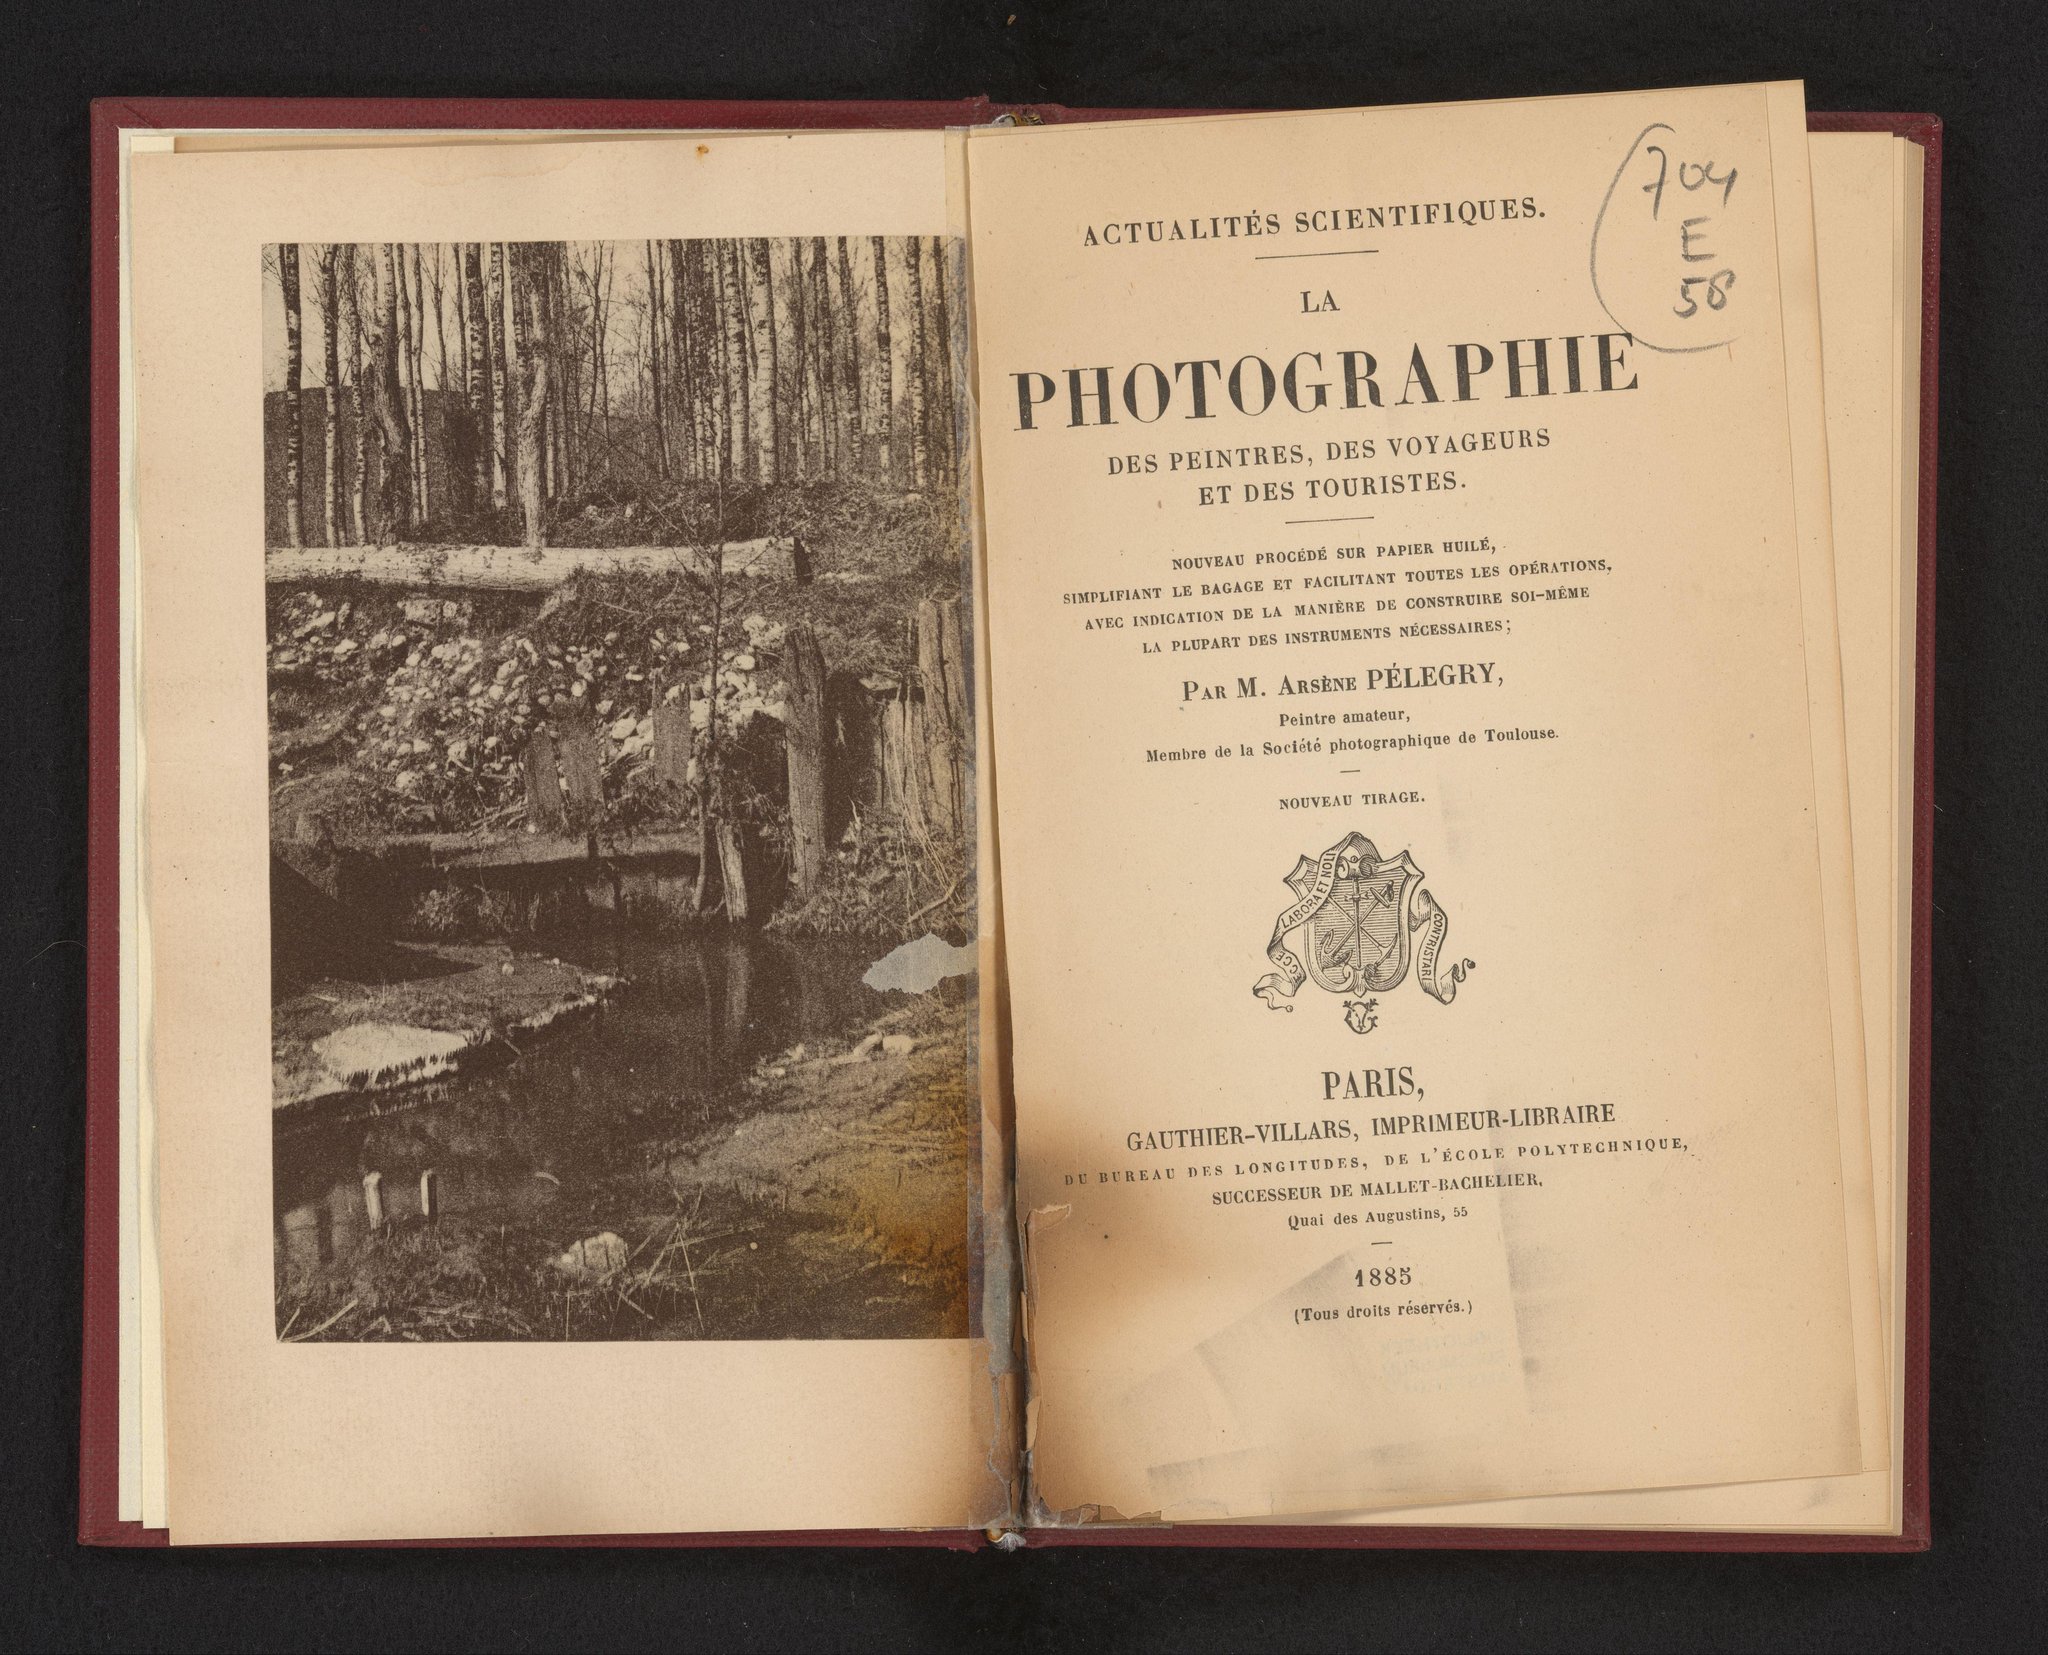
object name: page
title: Gezicht op een bos met beek en een omgevallen boom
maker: andré quinsac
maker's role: printer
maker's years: 1845-1891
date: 1880-1885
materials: paper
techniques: photograph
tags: forest, wood